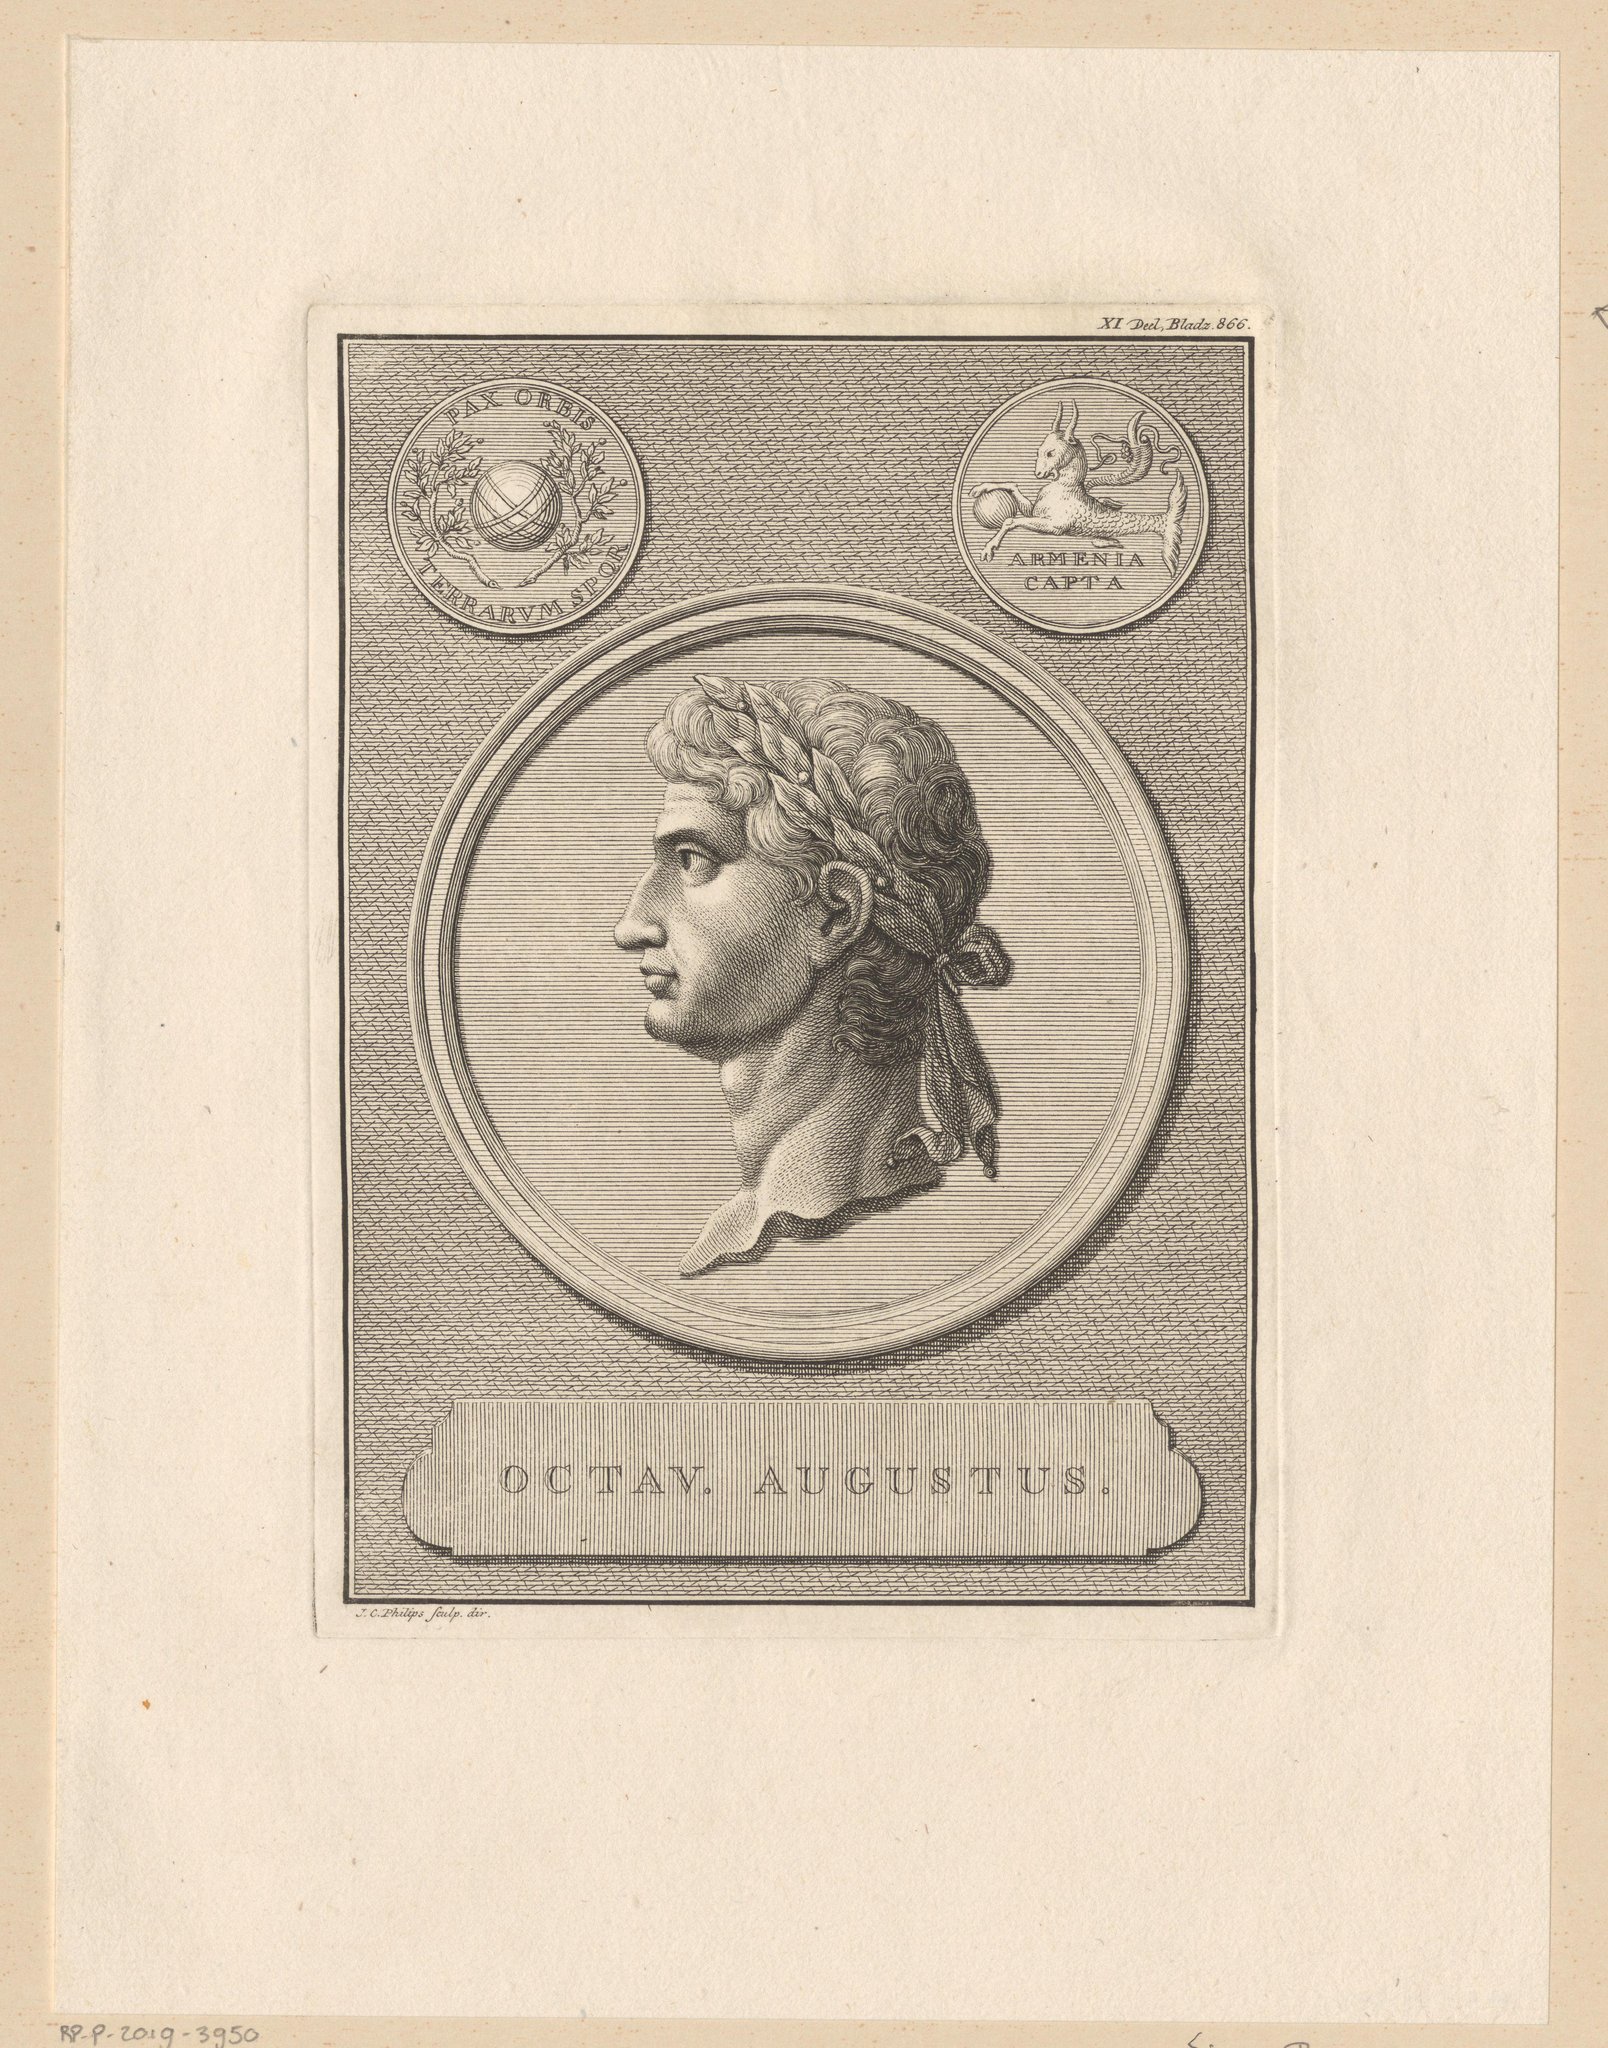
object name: book illustration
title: Portret van keizer Augustus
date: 1745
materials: paper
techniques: engraving, etching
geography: utrecht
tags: portrait of augustus, historical persons, coin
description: Prent uit: Westerbaen, Kornelis. Algemeene histori van het begin der wereld af tot den tegenwoordigen tijd toe. Utrecht: Herman Besseling, 1745, dl. 11.